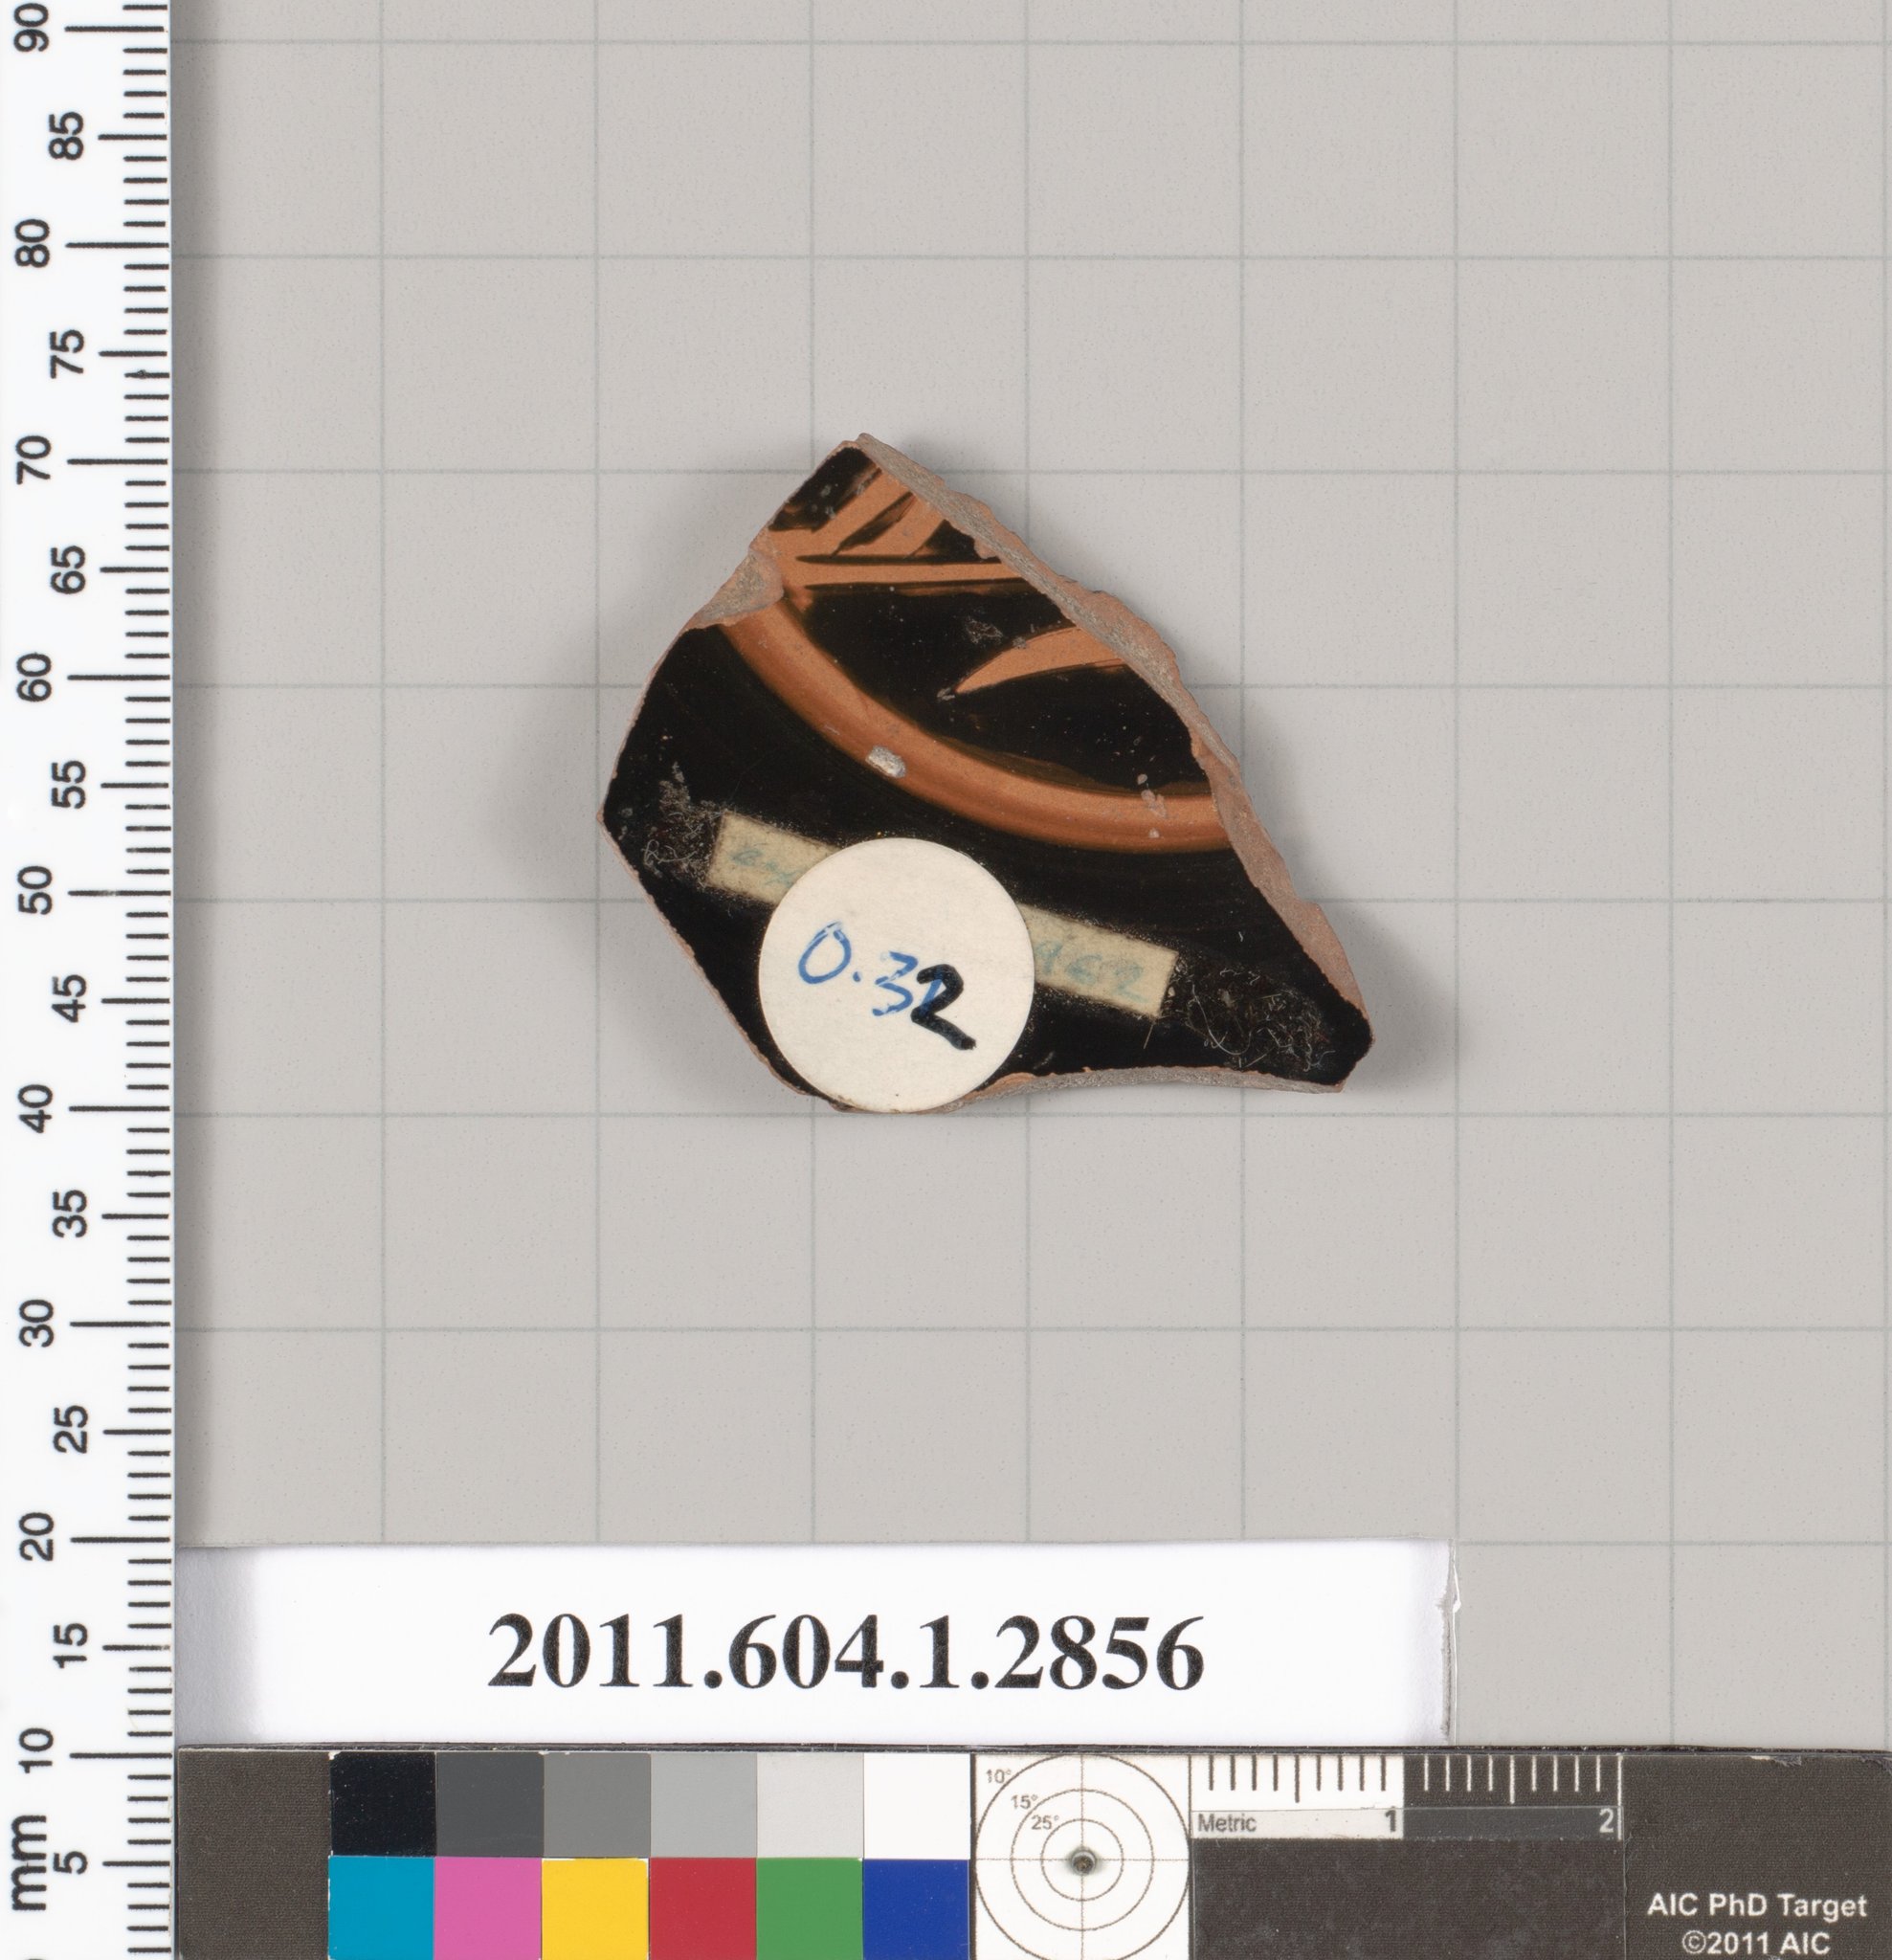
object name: kylix fragment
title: Terracotta fragment of a kylix (drinking cup)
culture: greek, attic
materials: terracotta